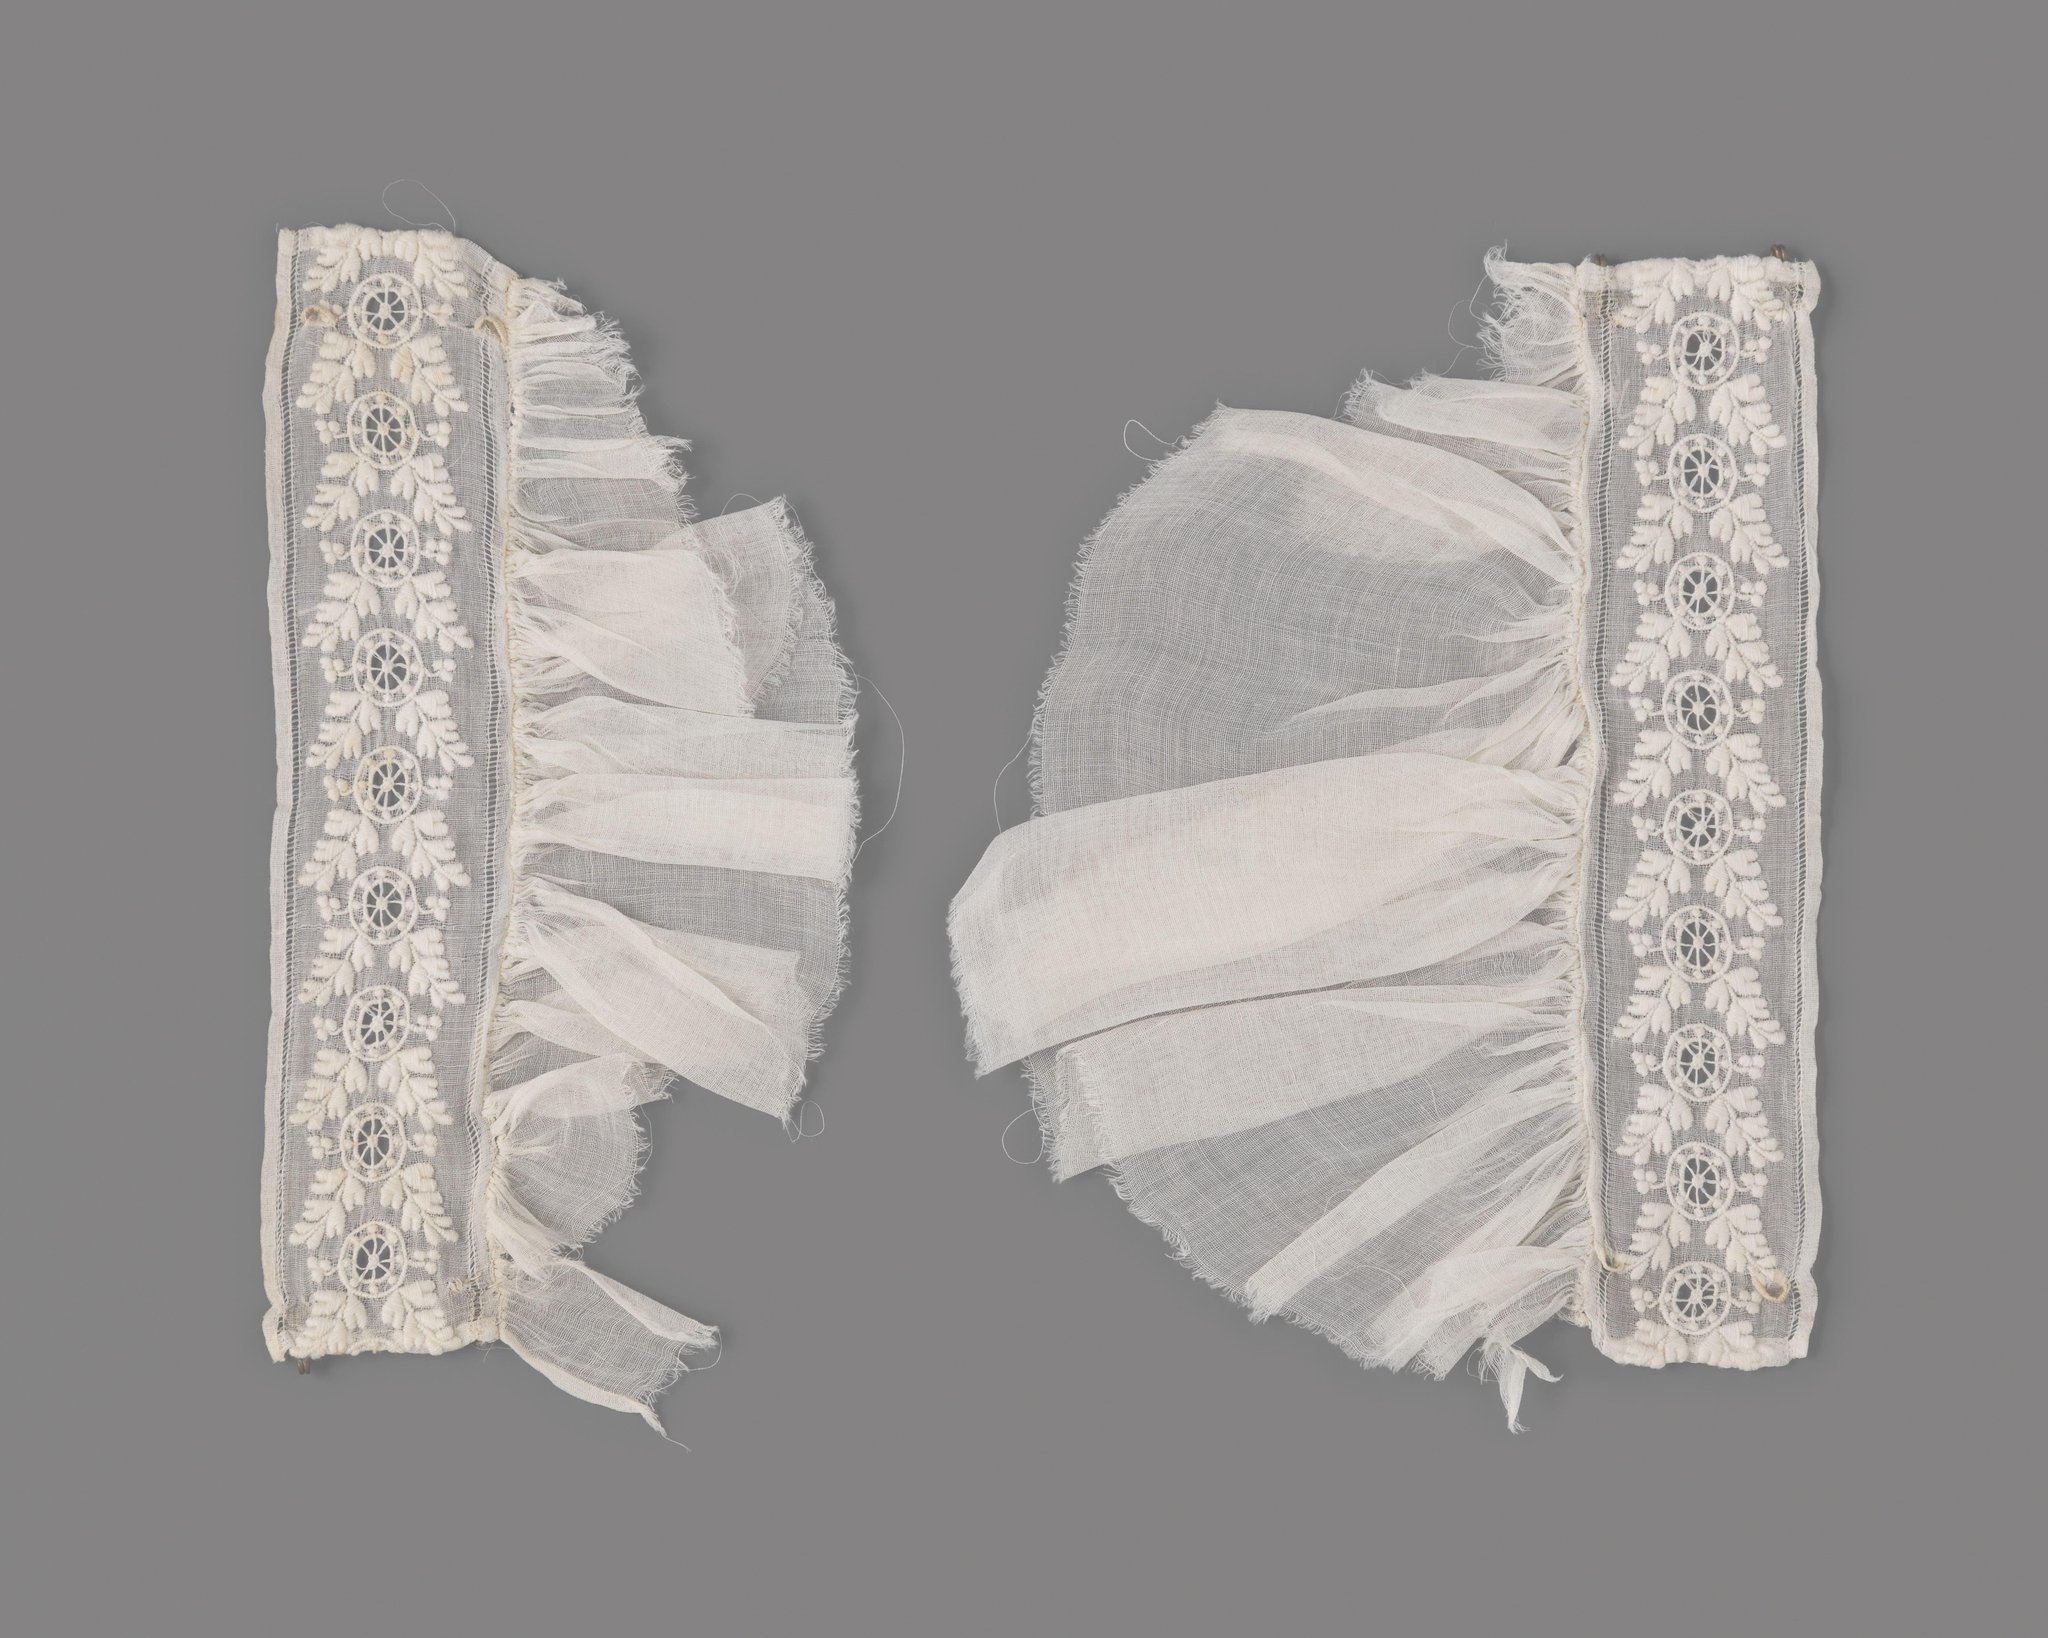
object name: cuff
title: Manchet met een strook spinnen in wielen tussen plumetisborduurwerk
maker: Anonymous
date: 1850-1920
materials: linen, metal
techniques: sewing, weave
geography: western europe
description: Manchet met een strook spinnen in wielen tussen plumetisborduurwerk.